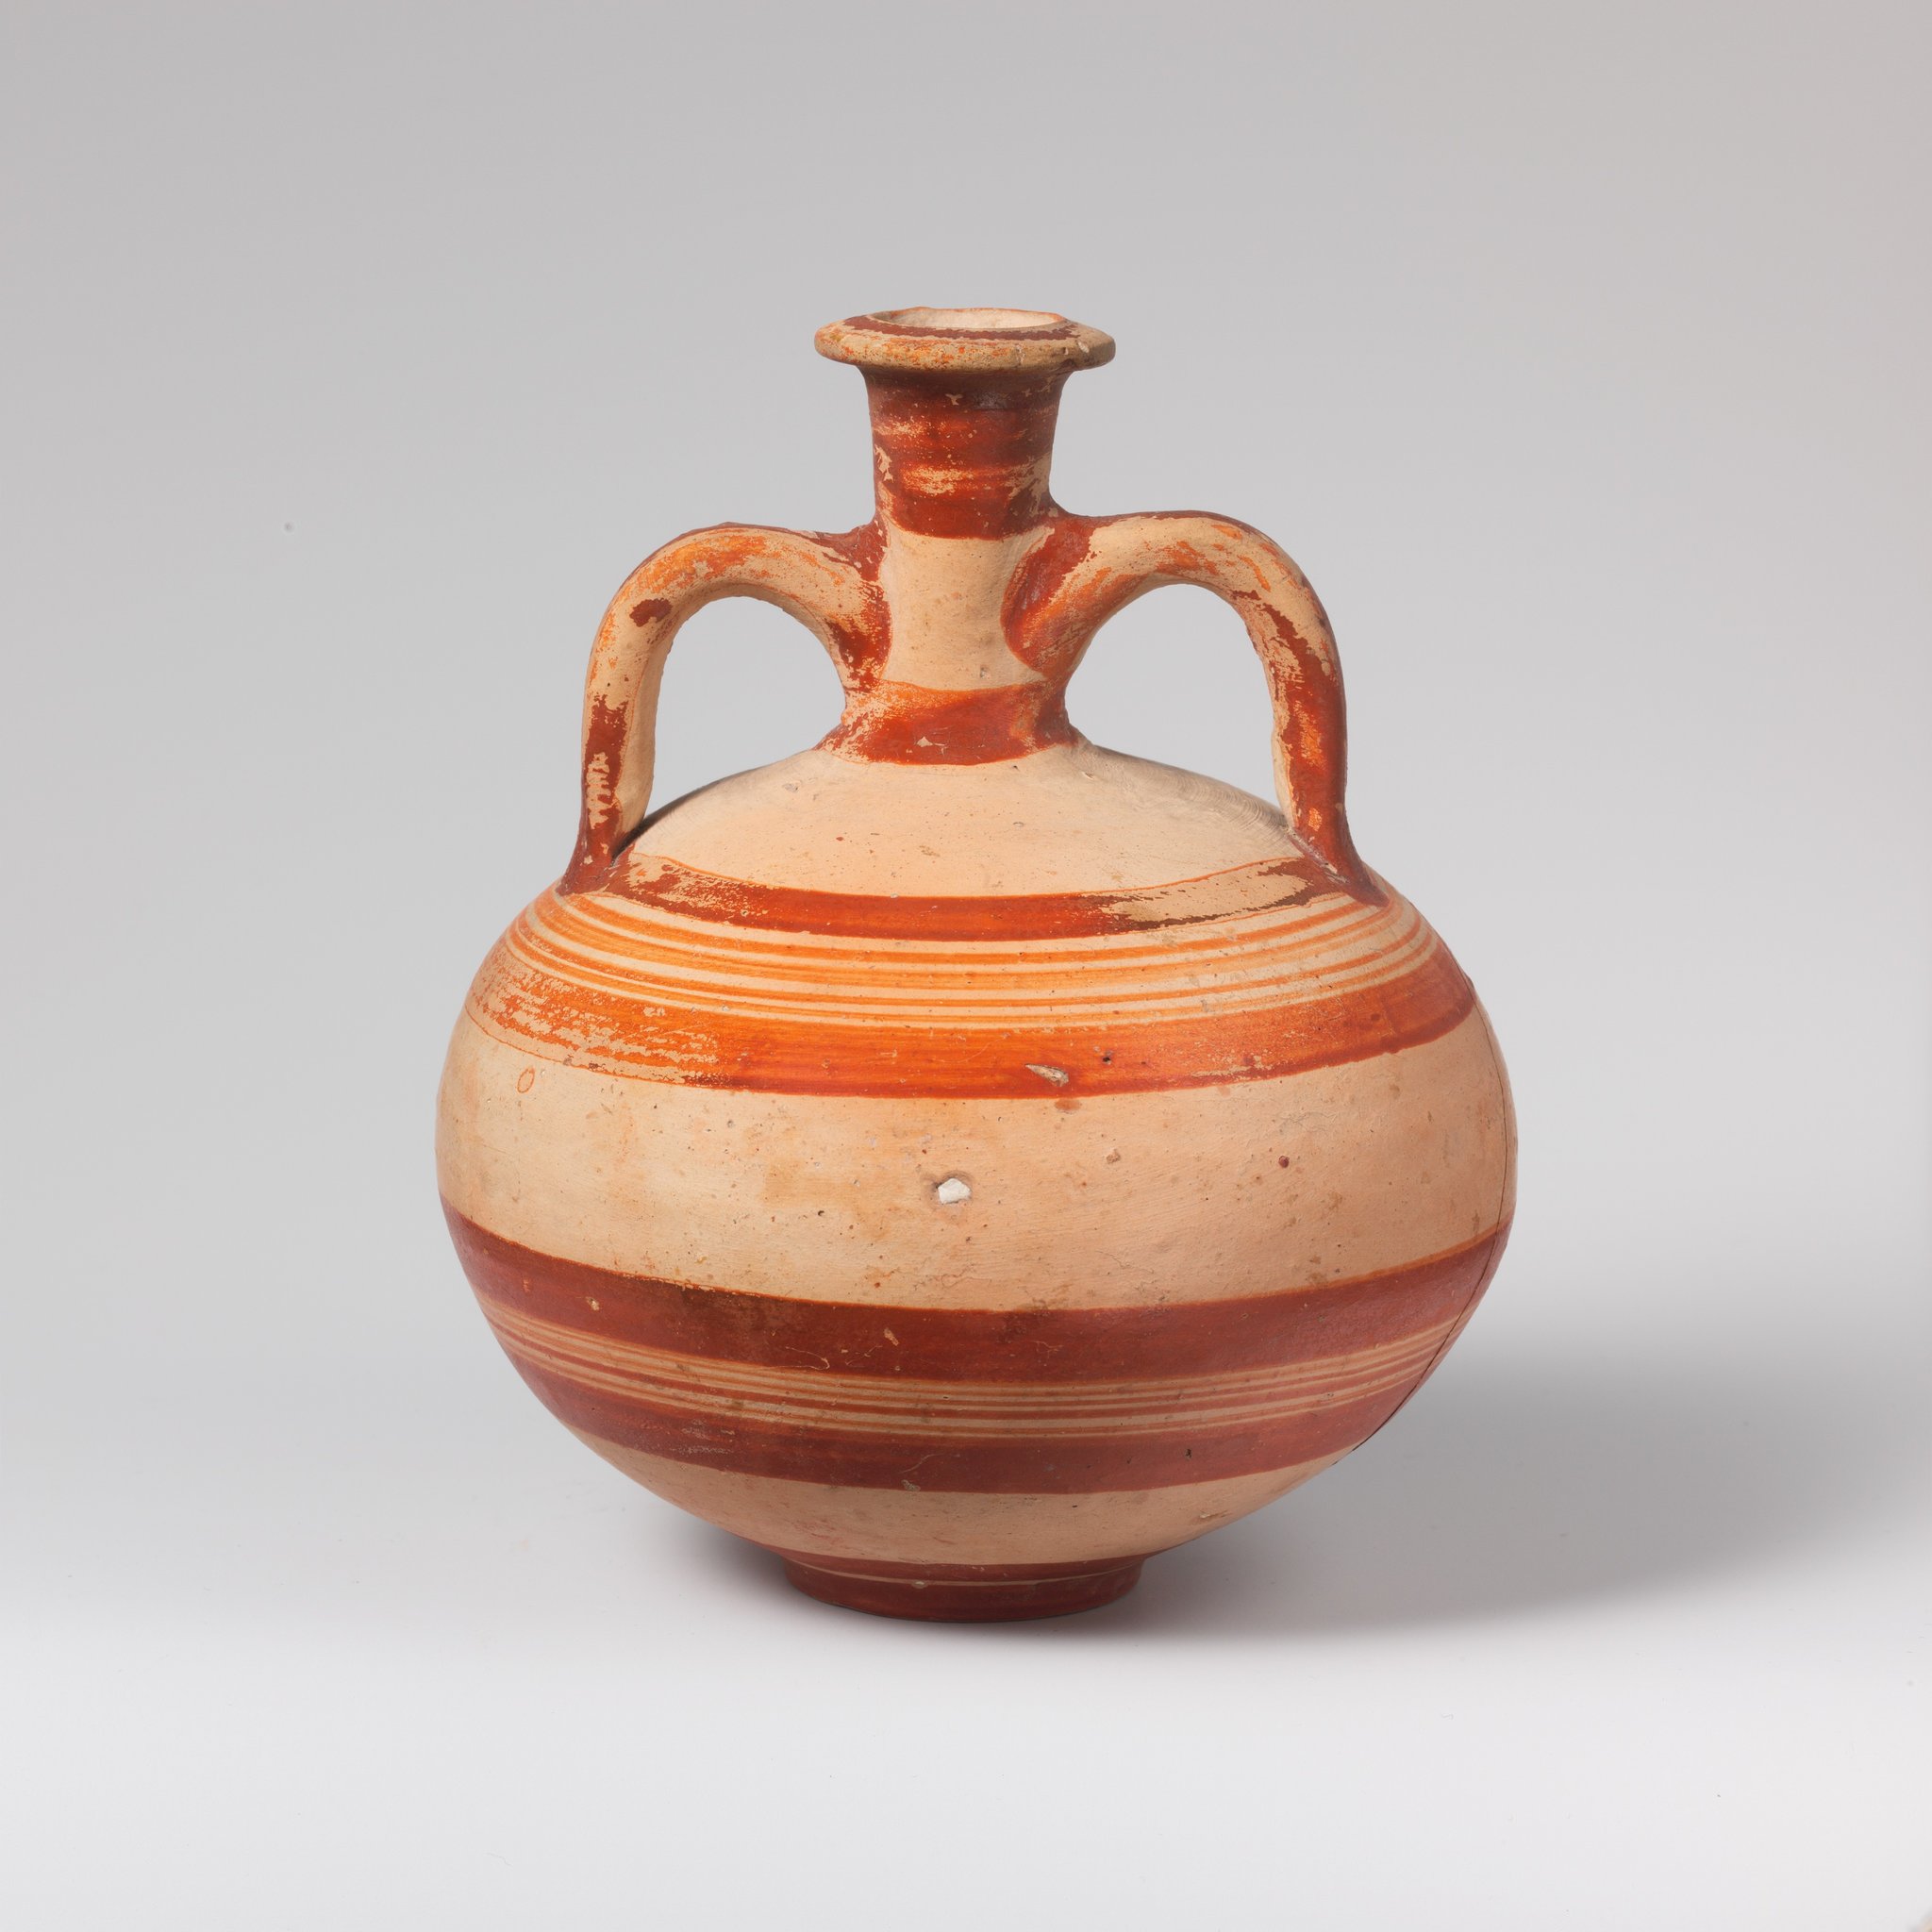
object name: vase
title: Terracotta globular flask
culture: mycenaean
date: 1400-1050 BCE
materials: terracotta